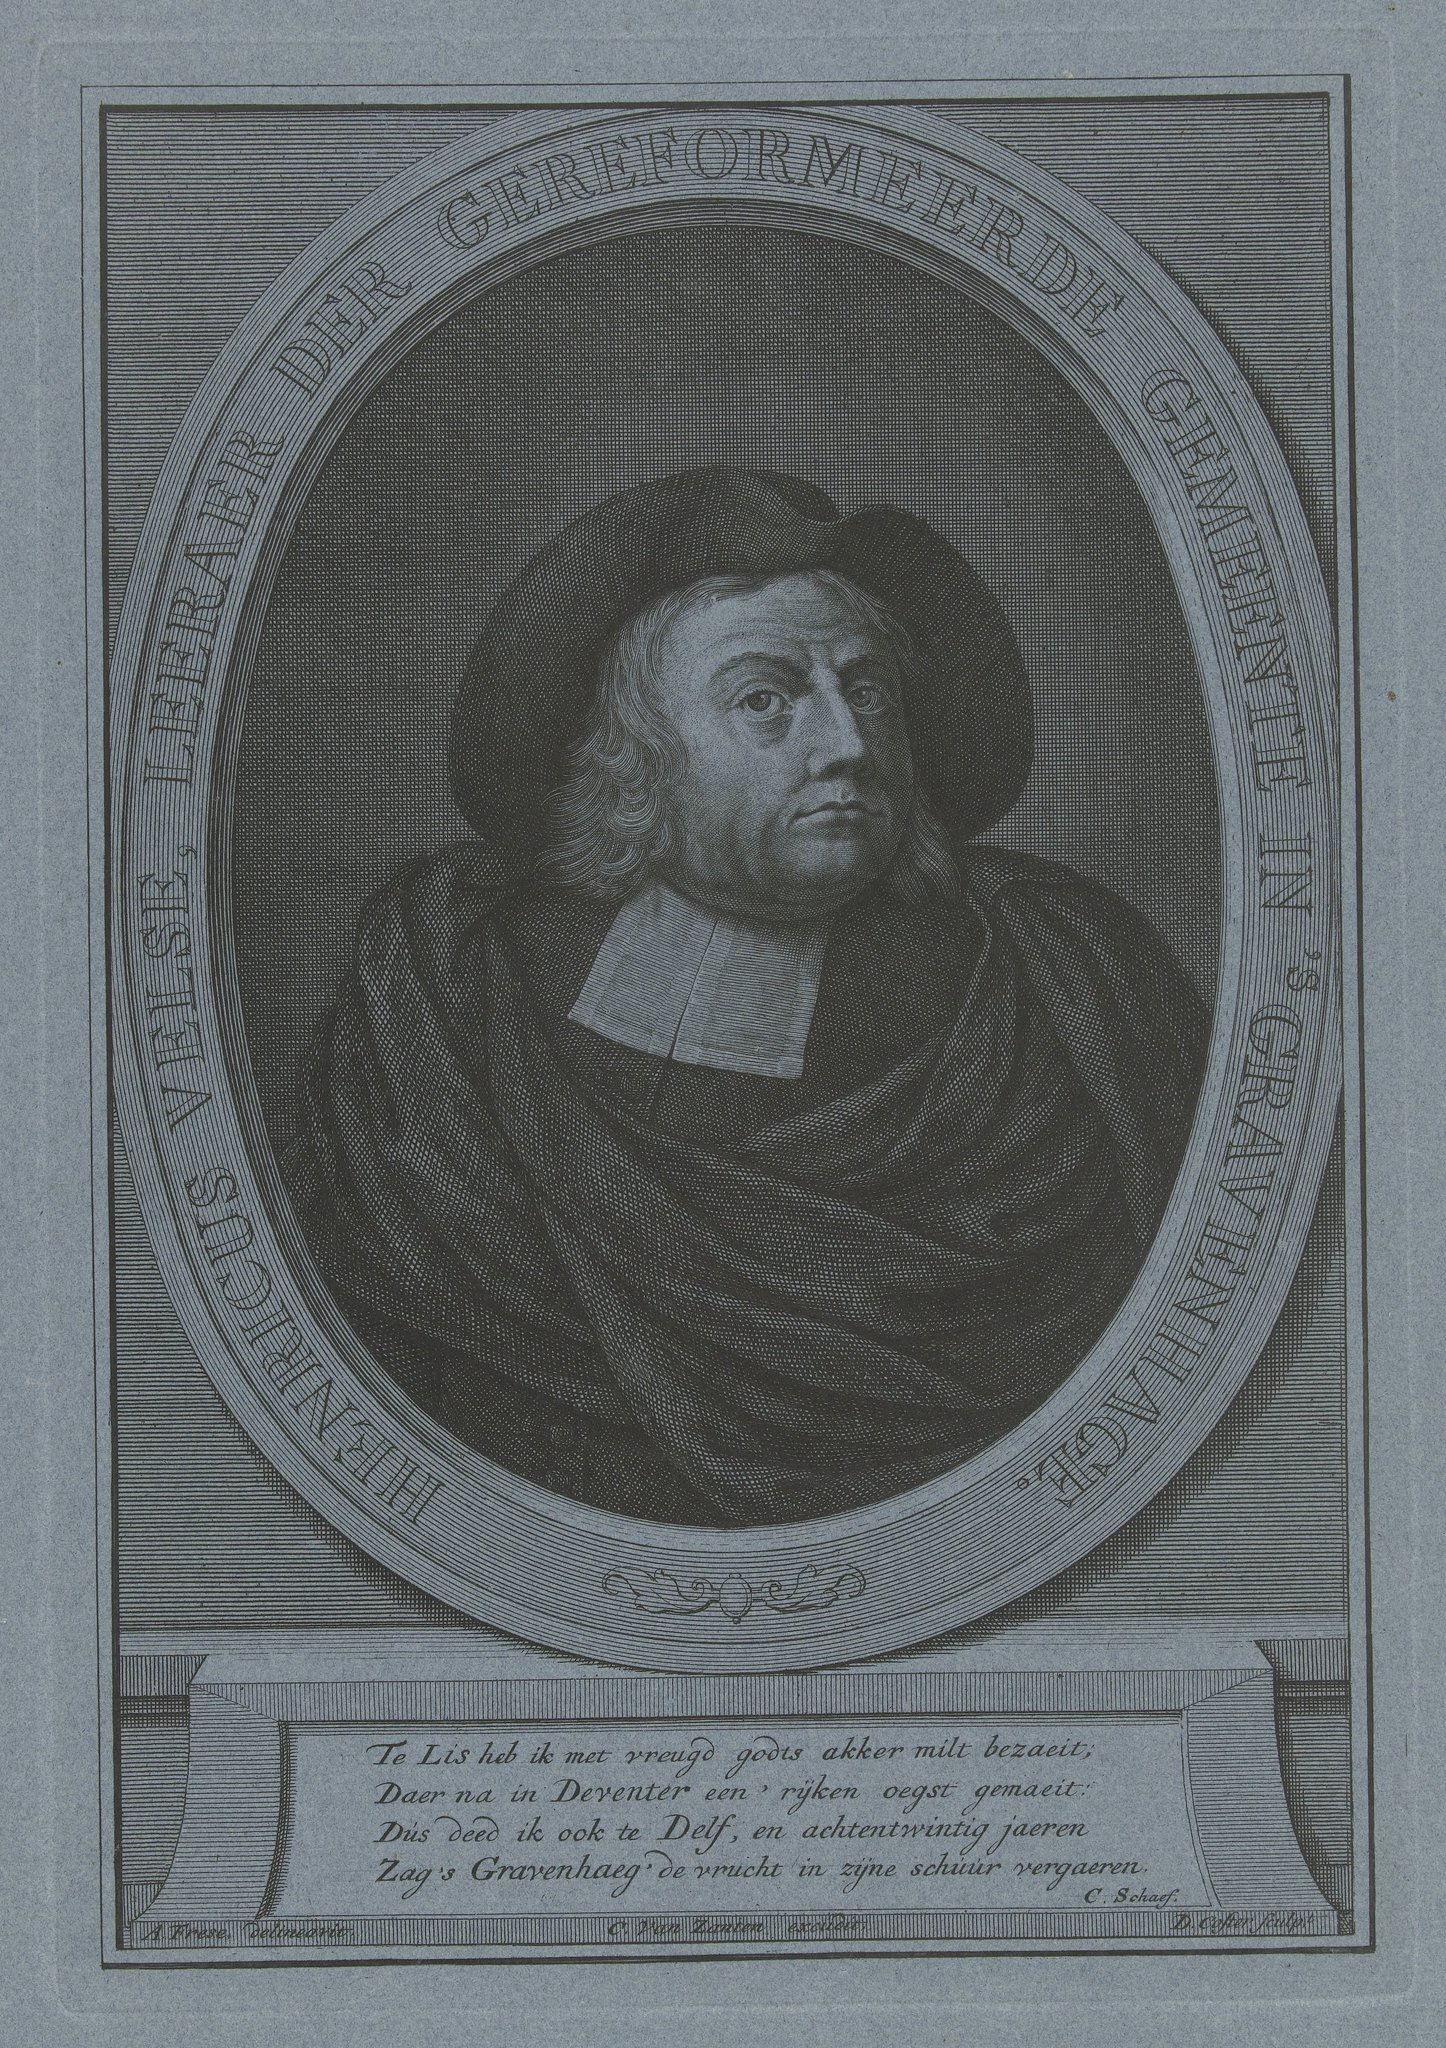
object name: print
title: Portret van Henricus van Velsen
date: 1740-1744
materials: paper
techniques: engraving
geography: the hague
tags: functionaries and dignitaries ~ protestant churches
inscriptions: collector's mark: Lugt 2228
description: Portret van Henricus Velsen, predikant van de gereformeerde gemeente te Den Haag, in ovaal met randschrift. Onder het portret een gedicht door C. Schaef.